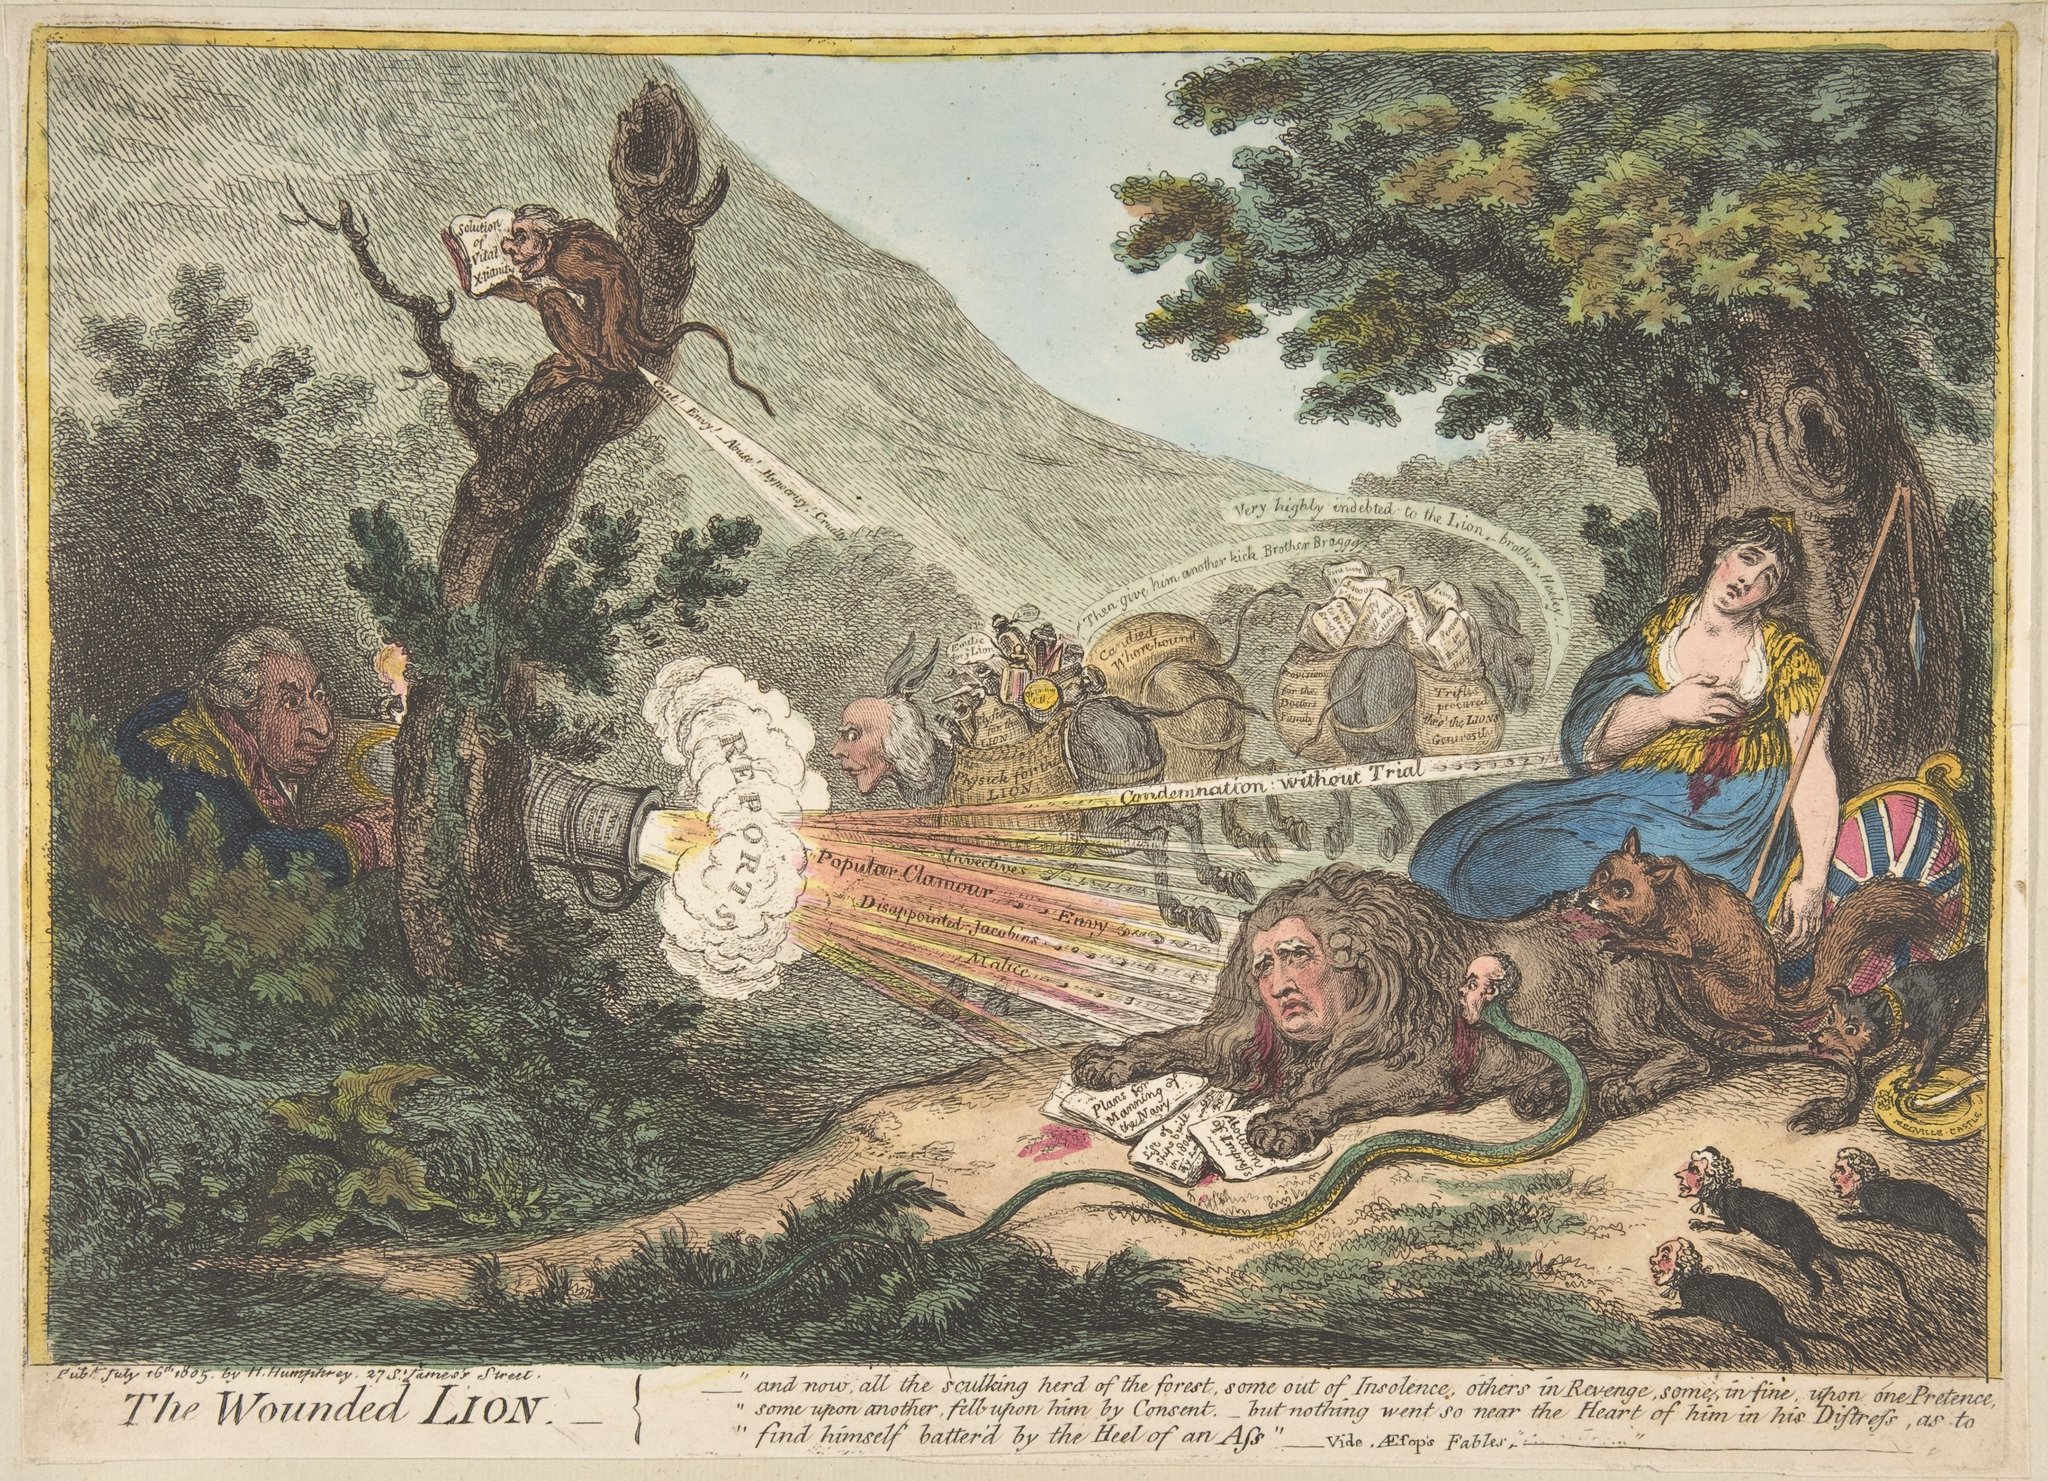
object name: print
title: The Wounded Lion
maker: james gillray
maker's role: artist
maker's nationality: british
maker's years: 1756-1815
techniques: etching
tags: satire,cannons,men,politics